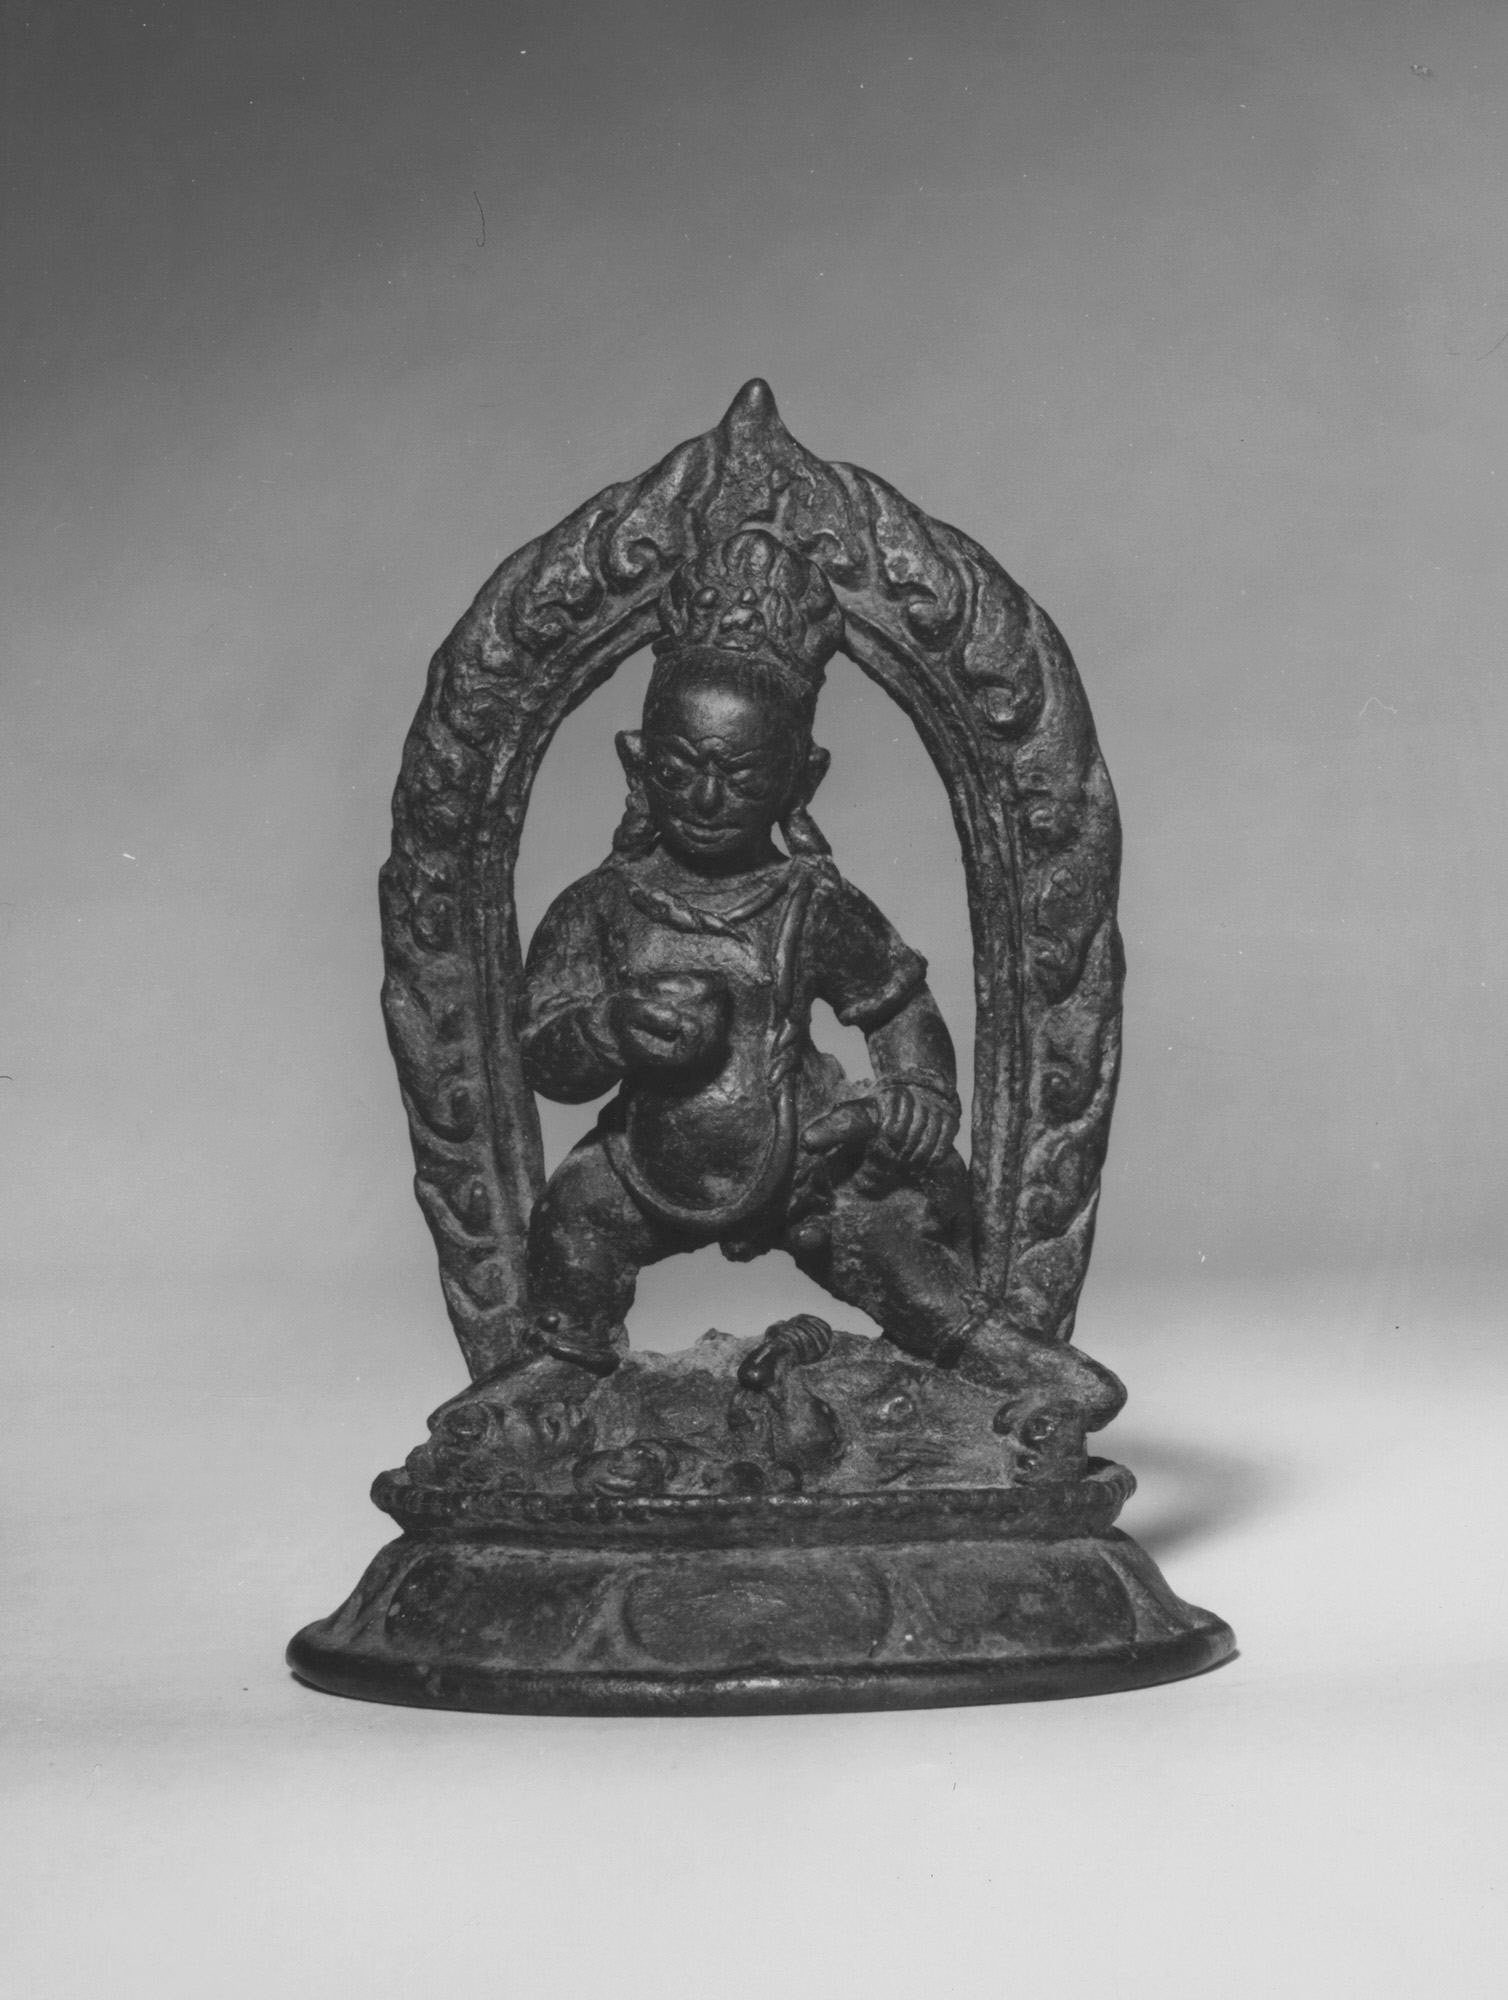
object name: figure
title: Kubera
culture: tibetan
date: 1201-1300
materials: bronze